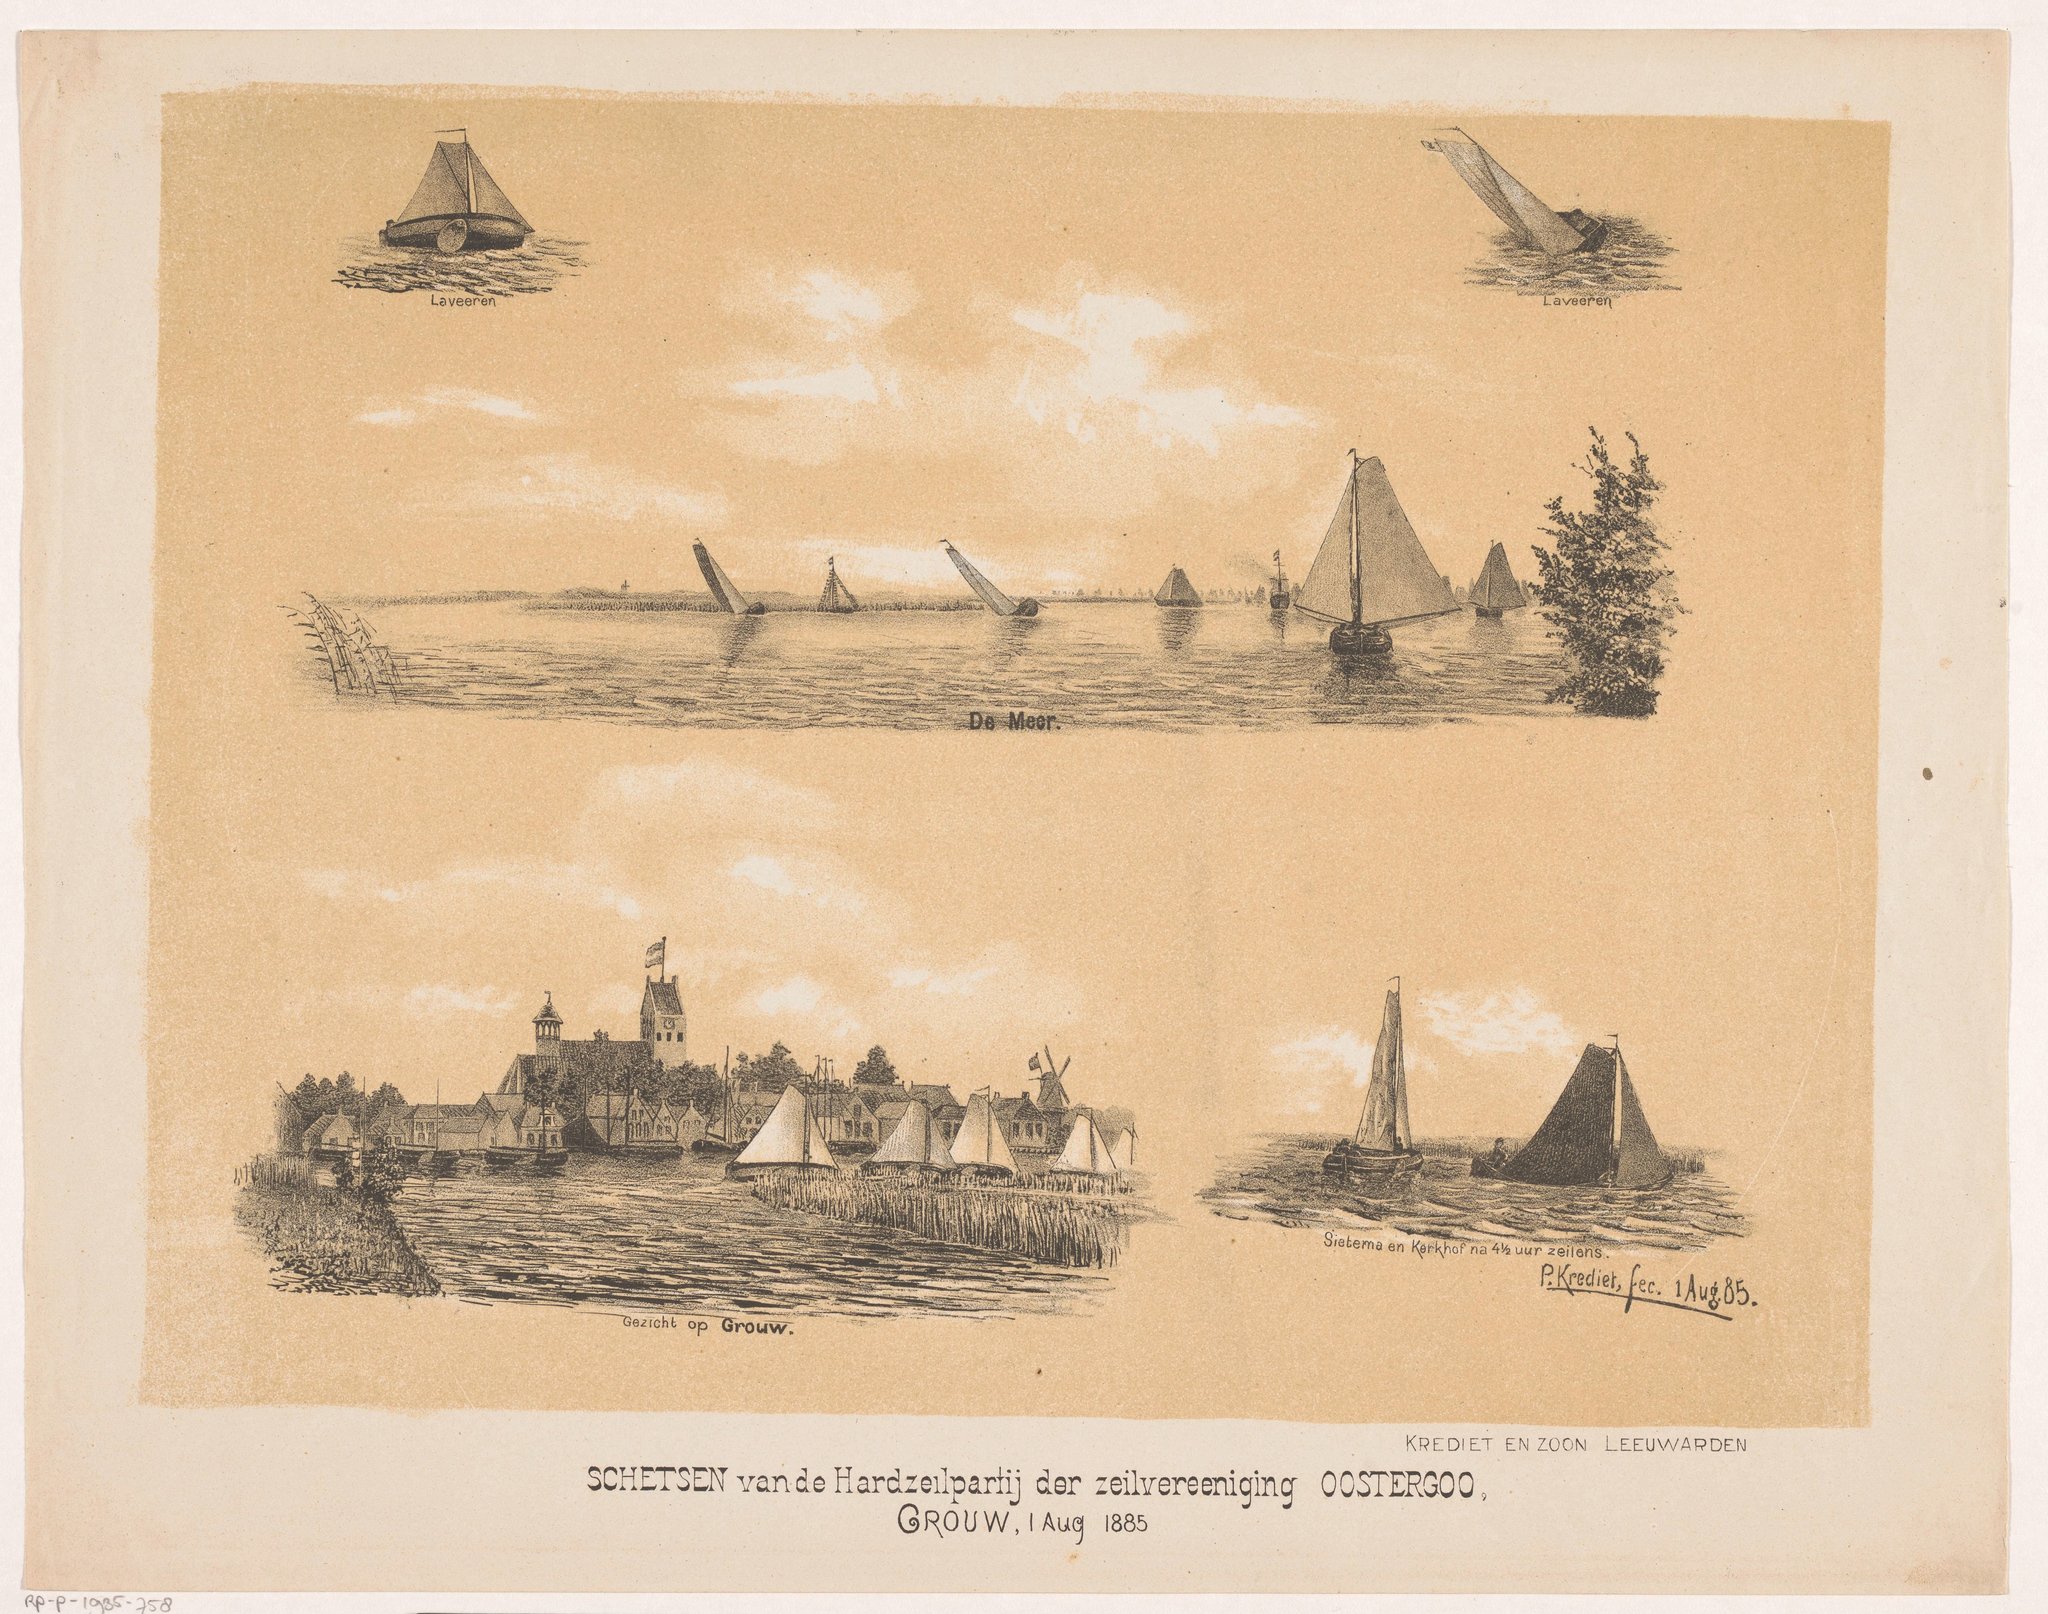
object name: print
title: Scènes uit een hardzeilwedstrijd bij Grouw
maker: piebe krediet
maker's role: print maker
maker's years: 1855-1936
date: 1885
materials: paper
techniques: tone lithography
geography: leeuwarden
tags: sailing-ship, sailing-boat, sailing (sport) (+ the contest (sports, games, etc.))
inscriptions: collector's mark: Lugt 2760, collector's mark: Lugt 2228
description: Links- en rechtsboven twee zeilschouwen met daaronder tweemaal het woord 'laveeren'. In het midden een gezicht op het Pikmeer met het onderschrift 'De Meer'. Linksonder een gezicht op Grouw. Rechtsonder twee kruisende zeilboten met het onderschrift 'Sietema en Kerkhof na 4½ uur zeilens'.